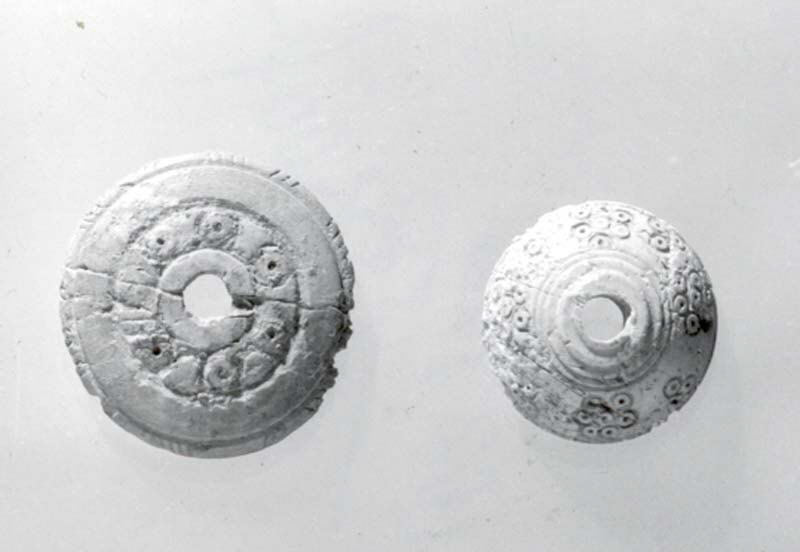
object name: button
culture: sasanian or islamic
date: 501-800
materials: bone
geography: iran